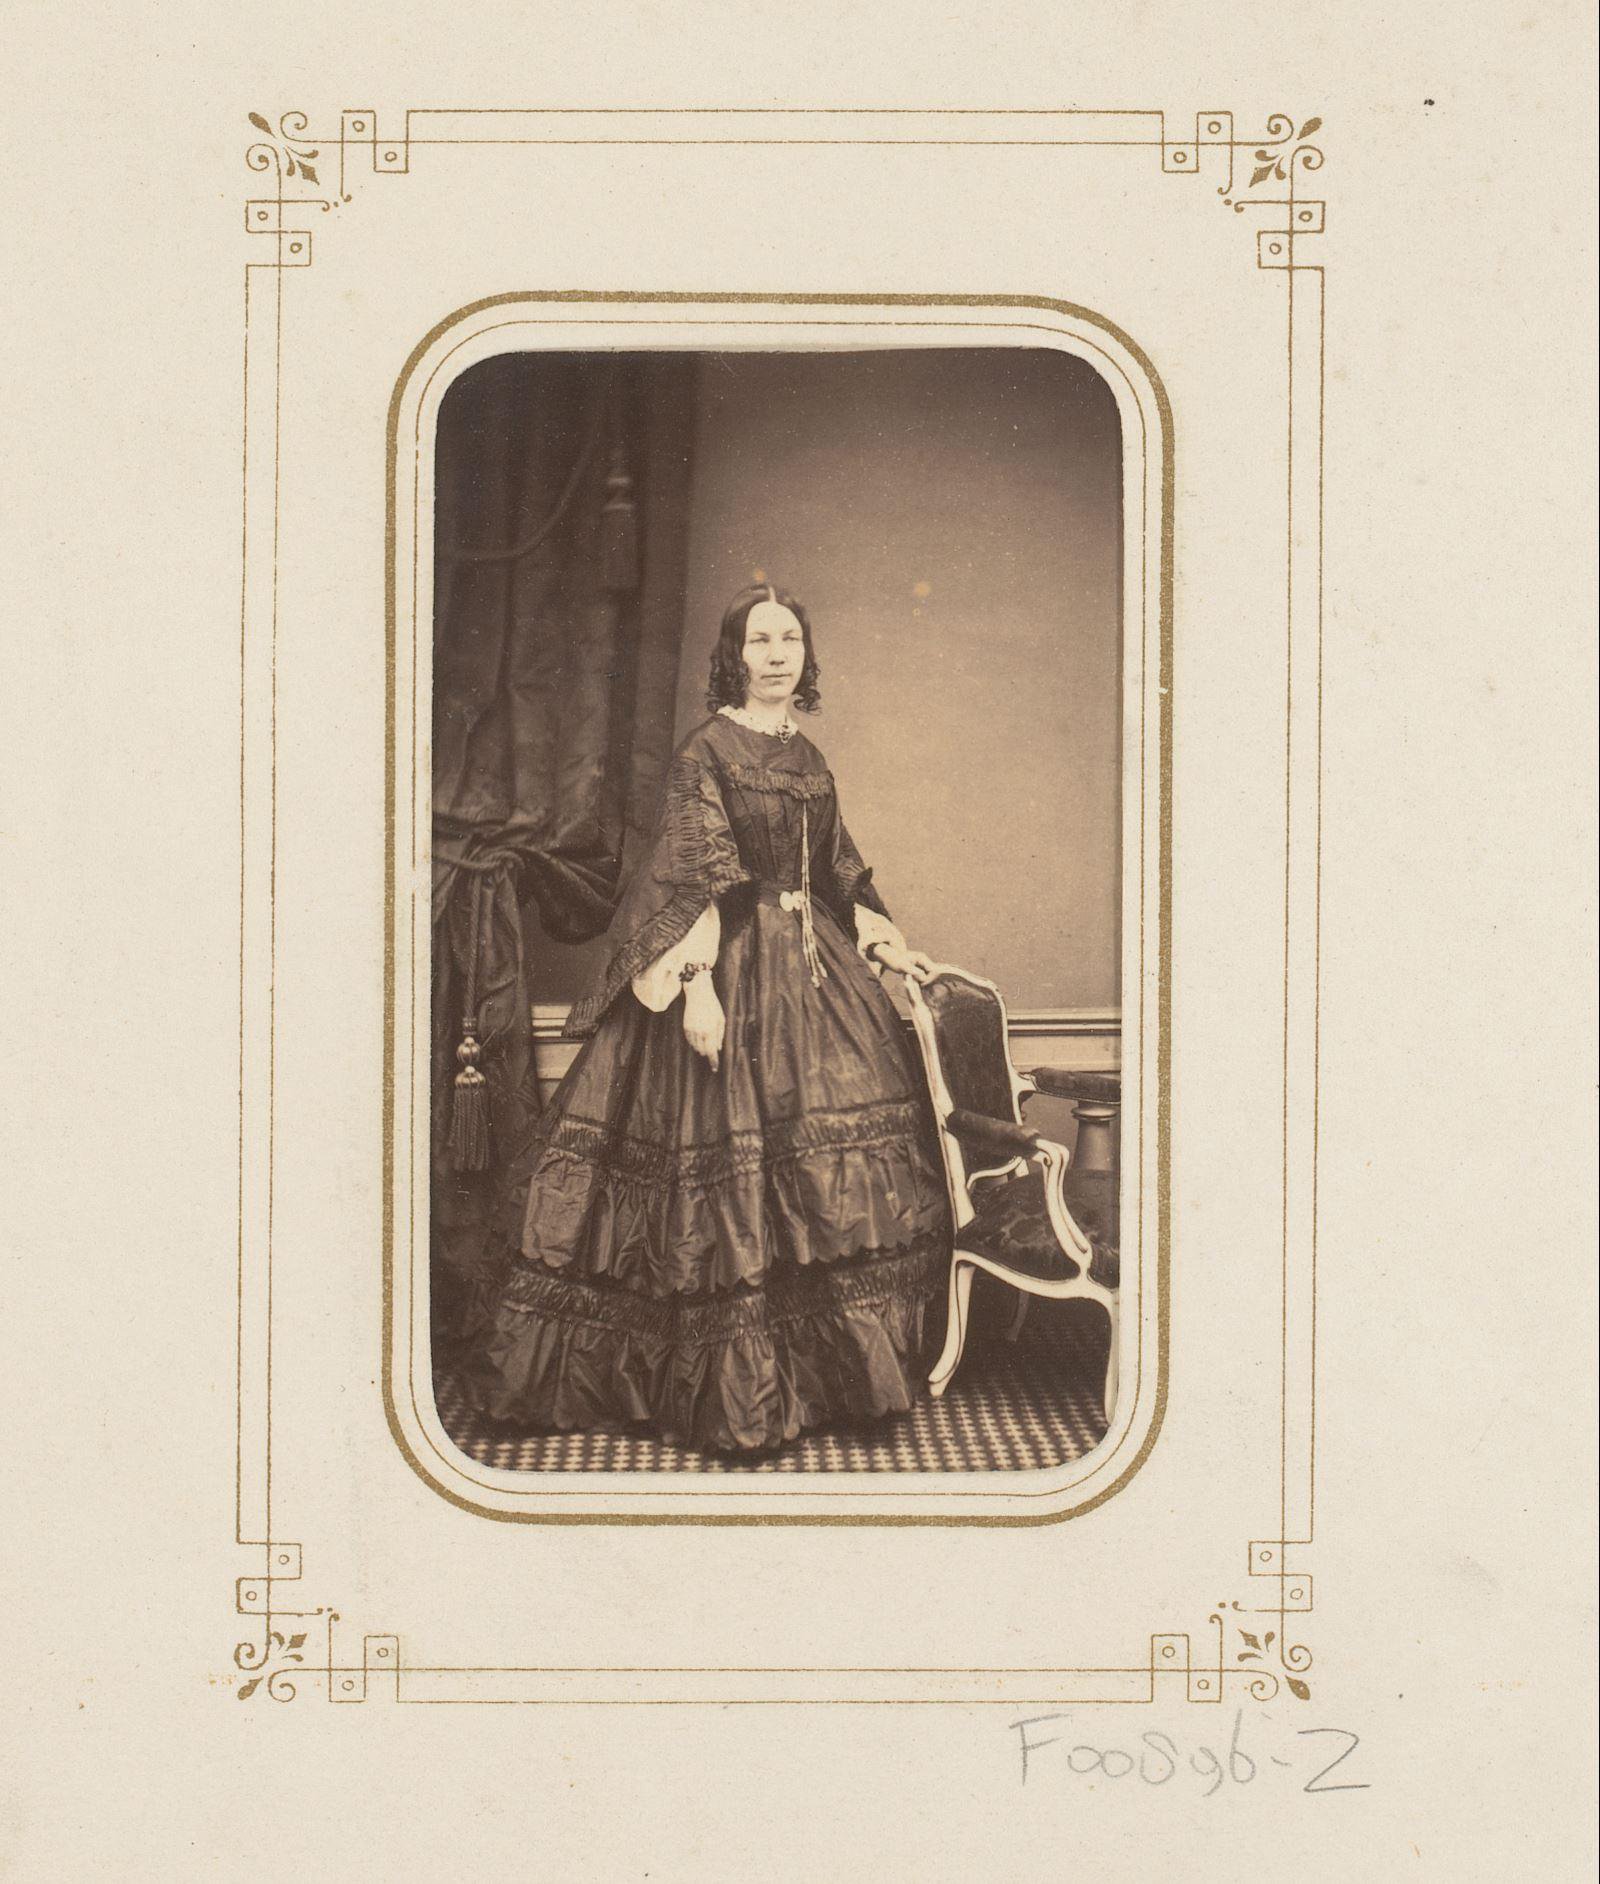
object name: carte de visite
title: Portret vrouw bij stoel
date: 1860-1890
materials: cardboard, photographic support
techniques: albumen print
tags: historical persons, standing figure - aa - female human figure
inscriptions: inscription: ‘54 Cheapside’